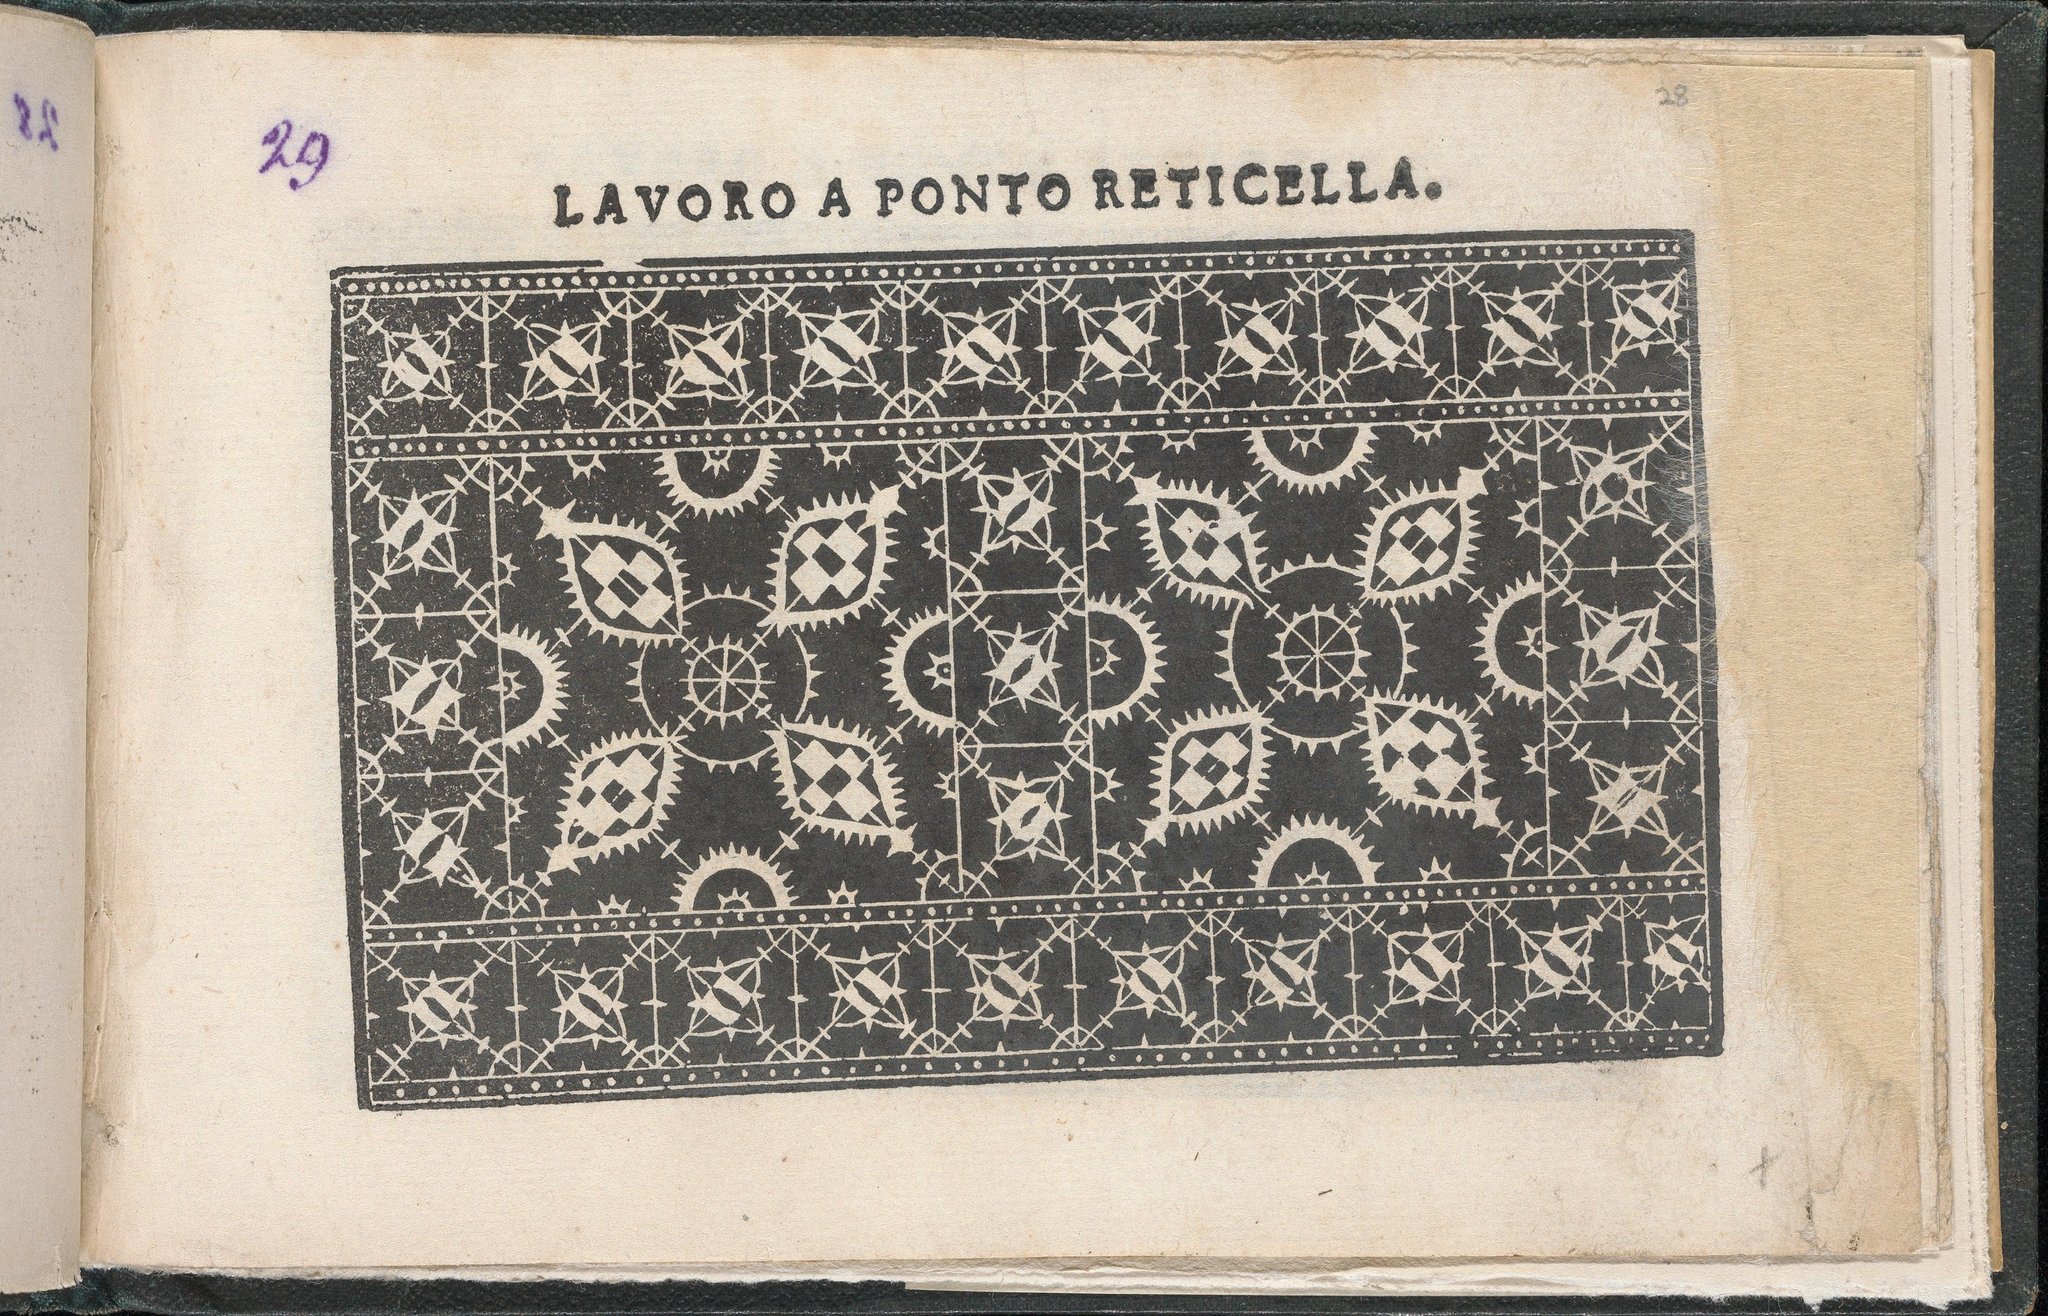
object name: book print ornament architecture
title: Gemma pretiosa della virtuose donne, page 28 (recto)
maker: isabella catanea parasole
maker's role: designer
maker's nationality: italian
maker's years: 1565-1625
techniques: woodcut